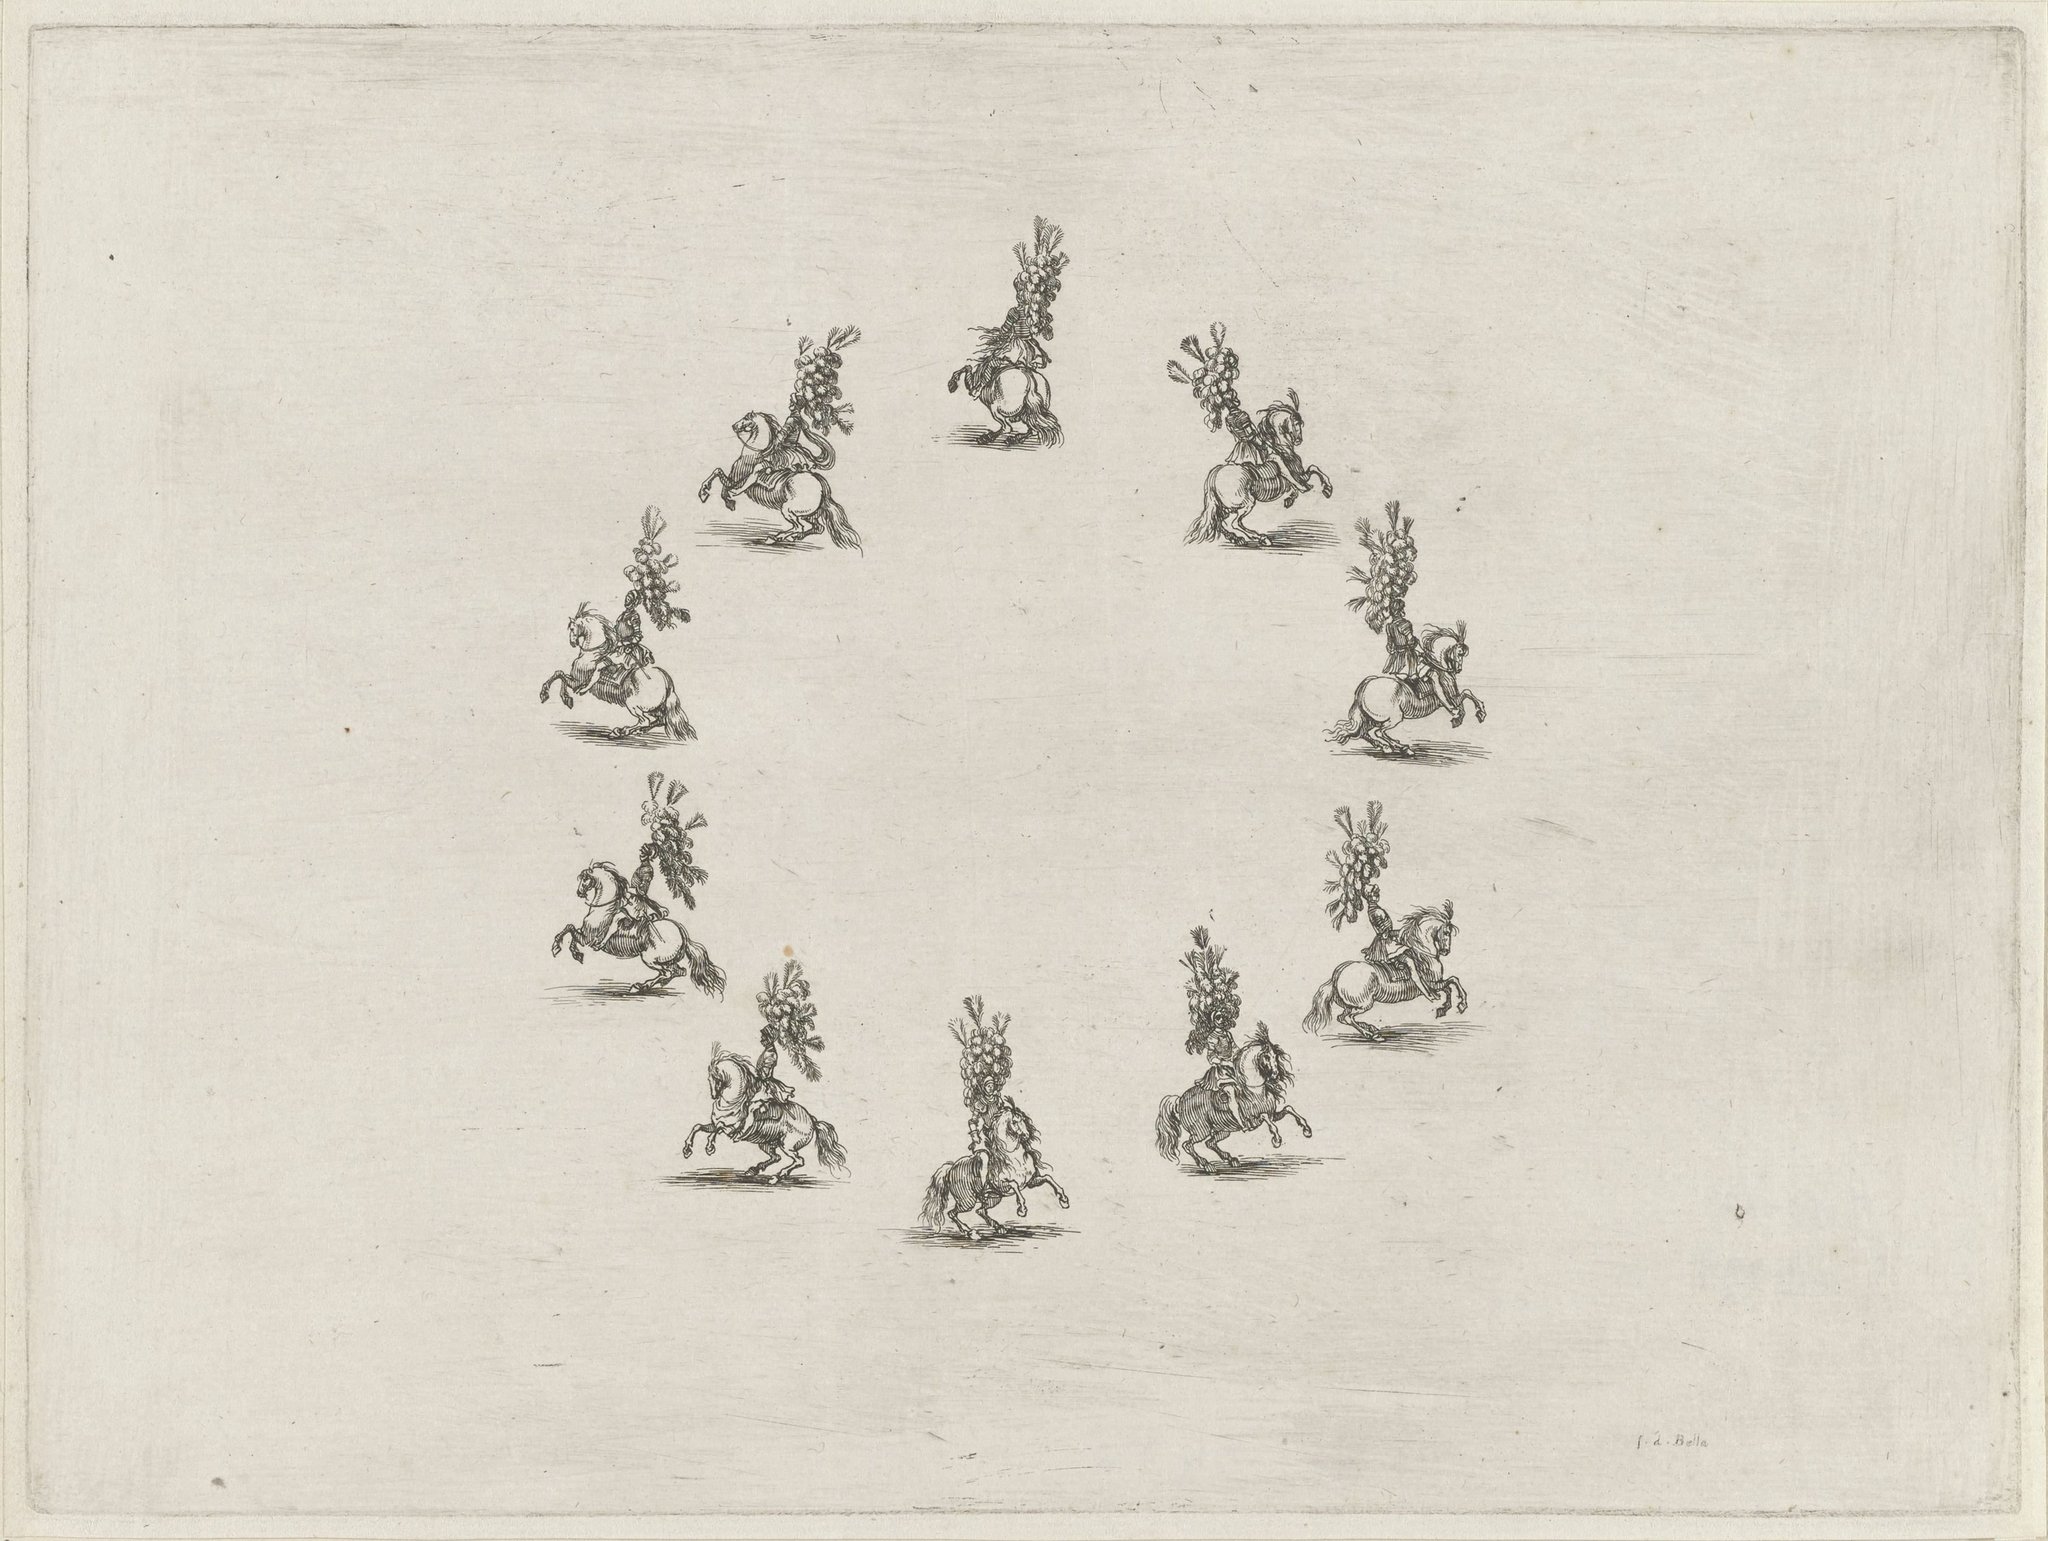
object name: book illustration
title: La gara delle Stagioni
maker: stefano della bella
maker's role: draughtsman, print maker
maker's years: 1610-1664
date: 1652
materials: paper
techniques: etching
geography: italy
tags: riding a horse, ass, or mule; rider, horseman, festivities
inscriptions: collector's mark: Lugt 240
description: Reeks van 14 prenten met voorstellingen van een carroussel ter ere van het bezoek van Aartshertogen Ferdinand Karl en Sigmund Franz en Aartshertogin Anna van Oostenrijk in Modena op 10 april 1652. Deze prenten zijn gebruikt als illustratie in 'La gara delle Stagioni, torneo a cavallo rappresentato in Modana nel passaggio de Serenissimi Arciduchi Ferdinando Carlo, Sigismondo Francesco d'Austria, et Arciduchessa Anna di Toscana; in Modana, 1652, con 14 figure grandi di Stefano Della Bella', Modena 1652.